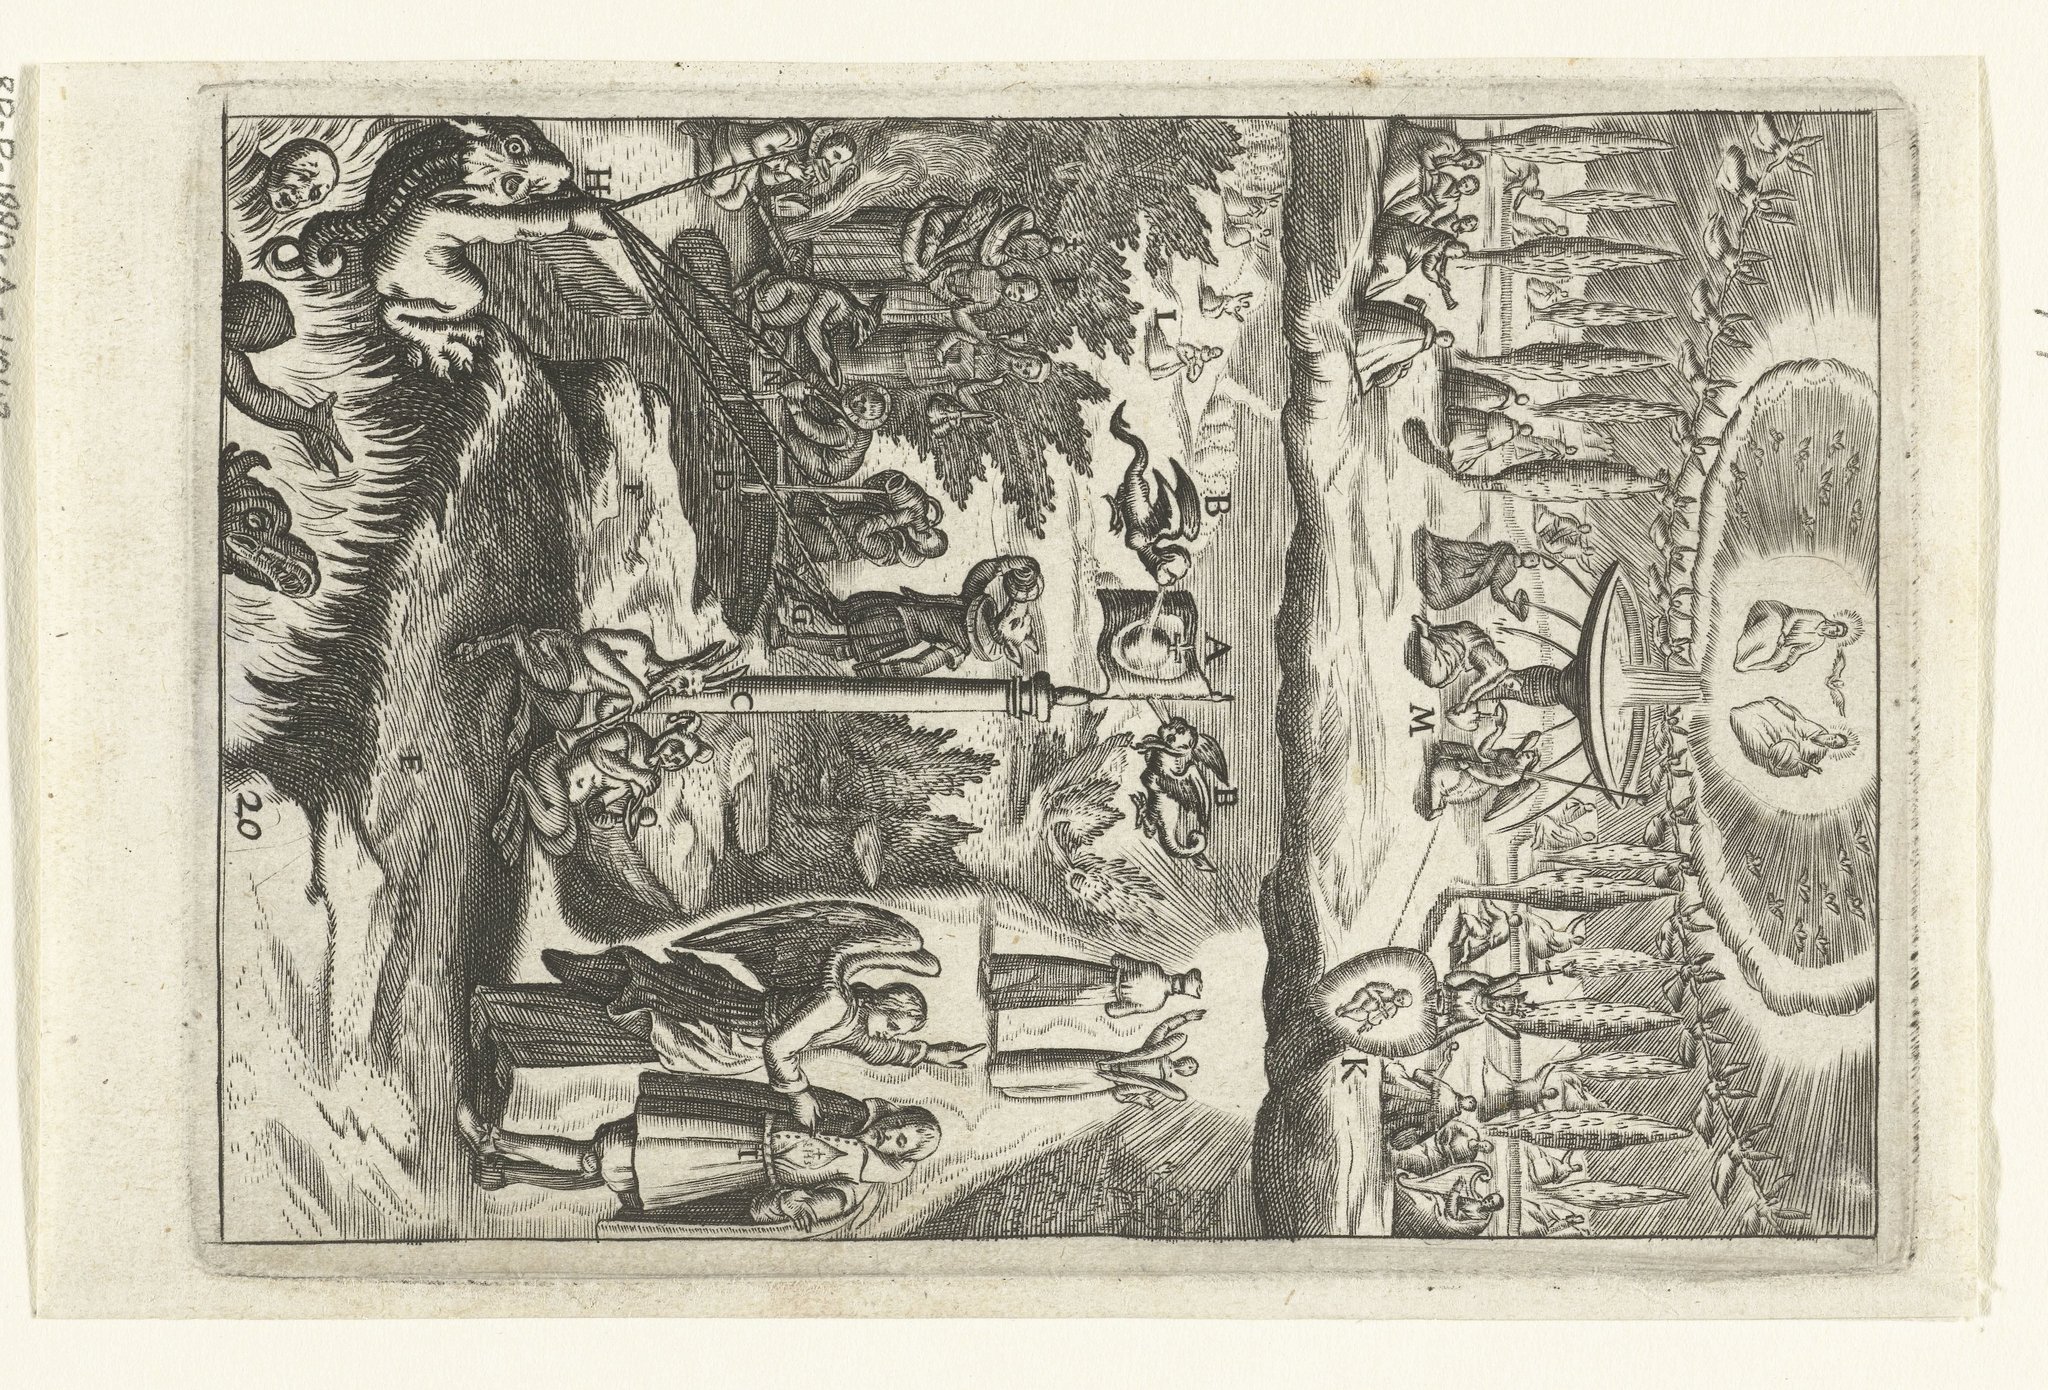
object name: book illustration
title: Den wech des eeuwich levens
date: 1620-1623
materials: paper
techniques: engraving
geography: antwerp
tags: the life of man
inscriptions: collector's mark: Lugt 2228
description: Prent uit: Antoine Sucquet, Den wech des eeuwich levens, beschreven int latijn : met beelden verlicht door Boëtius a Bolsvert, Antwerpen, Hendrick Aertssens, 1623, afb. tegenover p. 522